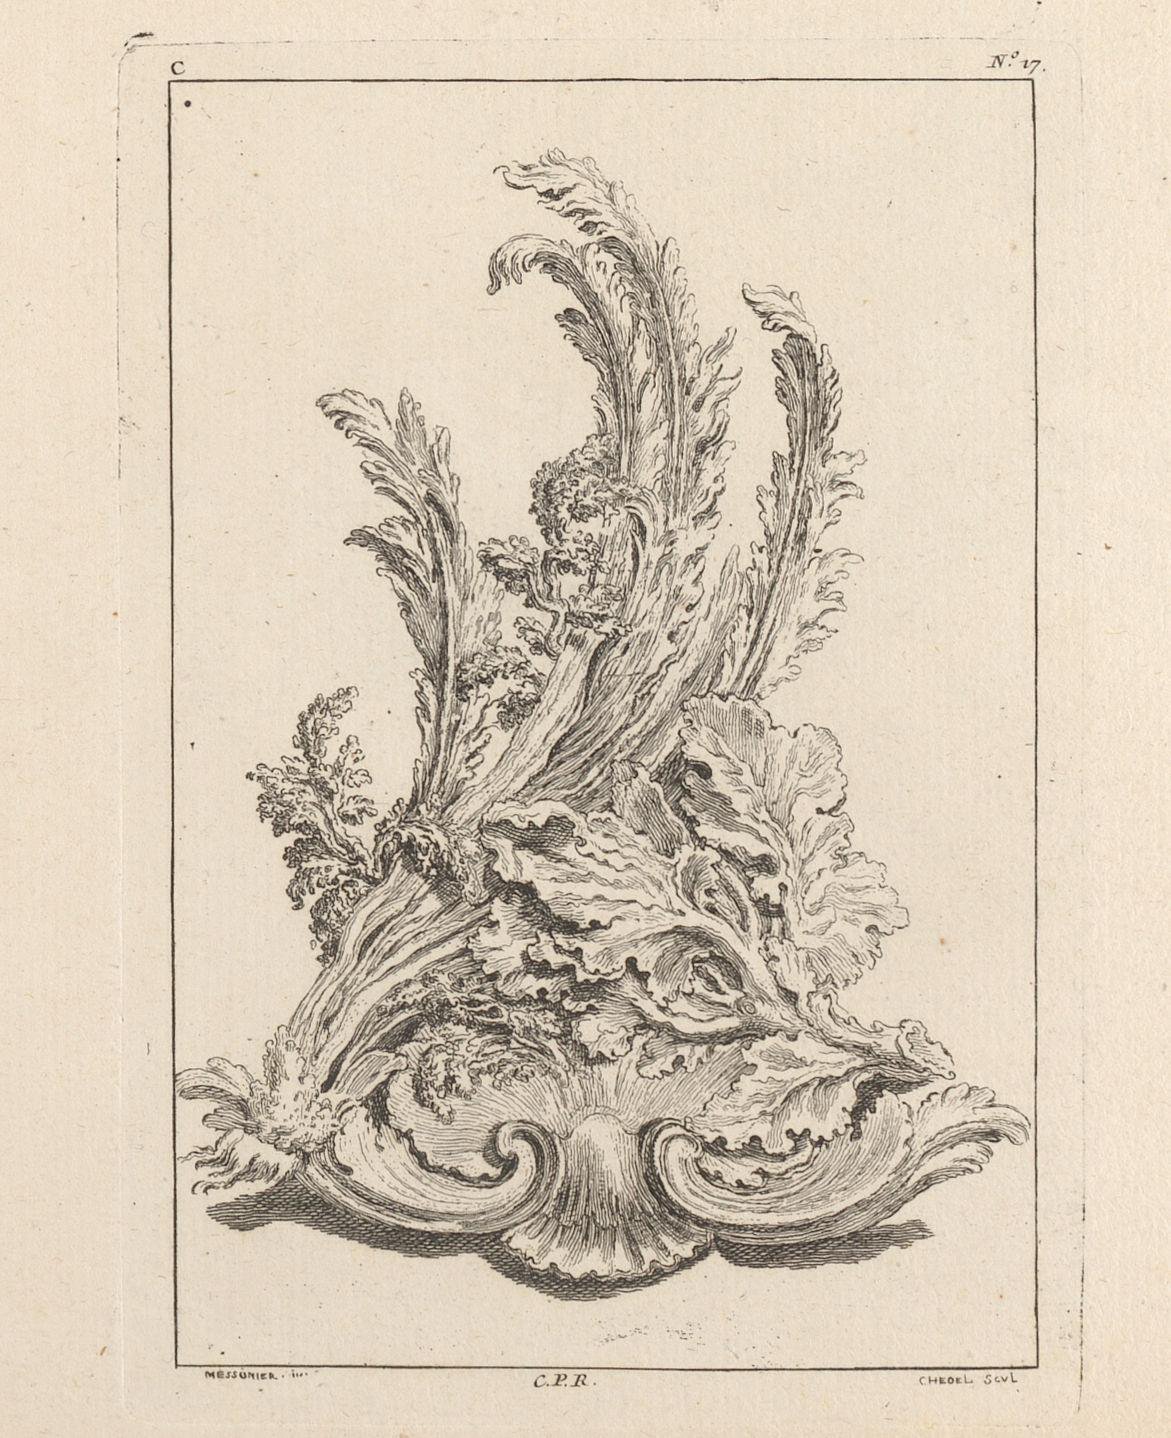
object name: print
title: Ornamenten en tafelschikkingen met groentes door Juste Aurele Meissonnier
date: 1738-1749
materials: paper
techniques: etching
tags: scallop, shell ~ ornament, vegetables and fruit; still life of vegetables and fruit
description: Prent uit een serie van zeven ornamentprenten met soortgelijke voorstellingen. Deze serie ( 'Livre de legumes') is onderdeel van de grotere reeks die het oeuvre van Meissonnier vertoont.